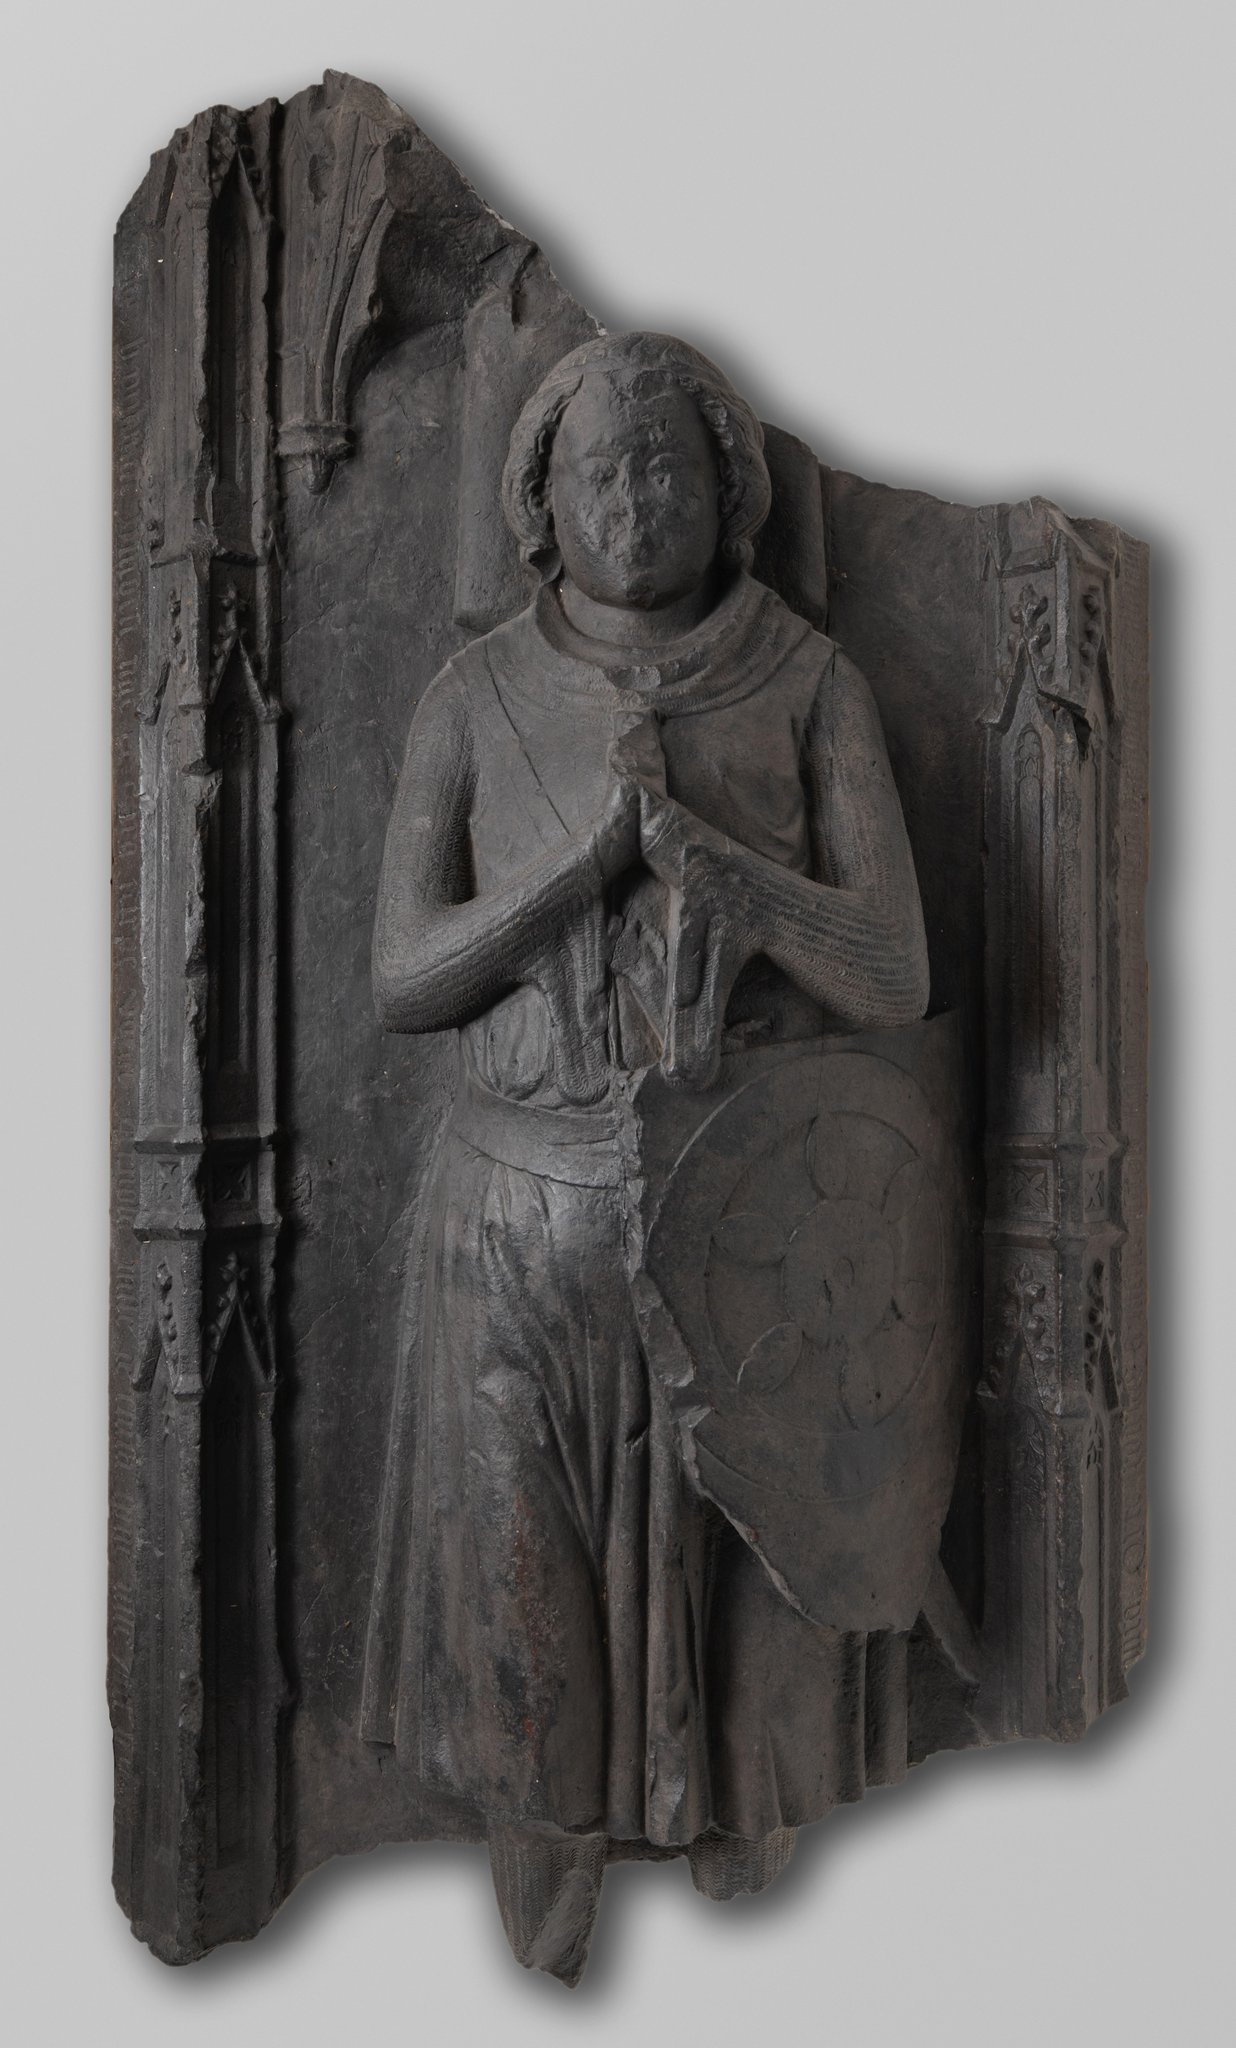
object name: tomb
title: Tomb of Arnold van der Sluis of Heusden, Knight (c. 1245-1296)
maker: Anonymous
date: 1296-1325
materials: limestone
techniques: carved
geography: meuse area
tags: bern (gelderland)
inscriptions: coat of arms, in reliëf, inscription: ‘[Qui fuerat gratus cun]ctis iac[et] h[ic] tumulat[us] Husde[n]si nat[us] ex clara stirpe vocat[us] Arnold[us] mile[s] de slusa sp[er]ne[re] viles Act[us] h[ic] novit falso[s] [a] seque removit Fortis formosus prudens erat atque animosus Justus pacifuc probitati semper amicus Finiit is vitam morum gravitate p]olita[m] Q[ua]rto redde[n]das a mense dec[em]bre kale[n]das. An[n]o milleno d[omi]ni noviesq[ue] noveno Et bis centeno terno quo[que] cu[m] duedeno Gaudeat in c[oelis ut hoc orat] quis[que] fidelis Hoc pater et flamen sacrum nat[us]q[ue] [det amen]’, coat of arms, coat of arms, in relief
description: De tombe heeft een dekplaat, waarop tussen twee fialen de overledene met open ogen en met de handen in biddende houding, liggend met het hoofd op een kussen onder een baldakijn is weergegeven. Hij draagt maliënkolder en wapenrok, van de rechterschouder hangt de bandelier, waaraan het schild, dat het zwaard vrijwel geheel bedekt. Om het middel draagt hij een brede riem, om het hoofd een band. Op het schild het geslachtswapen, tevens stadswapen van Heusden. In elk der beide lange zijden van de tombenegen ondiepe nissen met blinde venstertraceringen, waarin vierpassen; aan het hoofdeinde vier en aan het voeteneinde drie nissen met venstertraceringen. Het voeteneinde vertoont in de middelste nis een staande, in een lang gewaad geklede jonge persoon met een band (?) in het haar en met de handen in biddende houding.